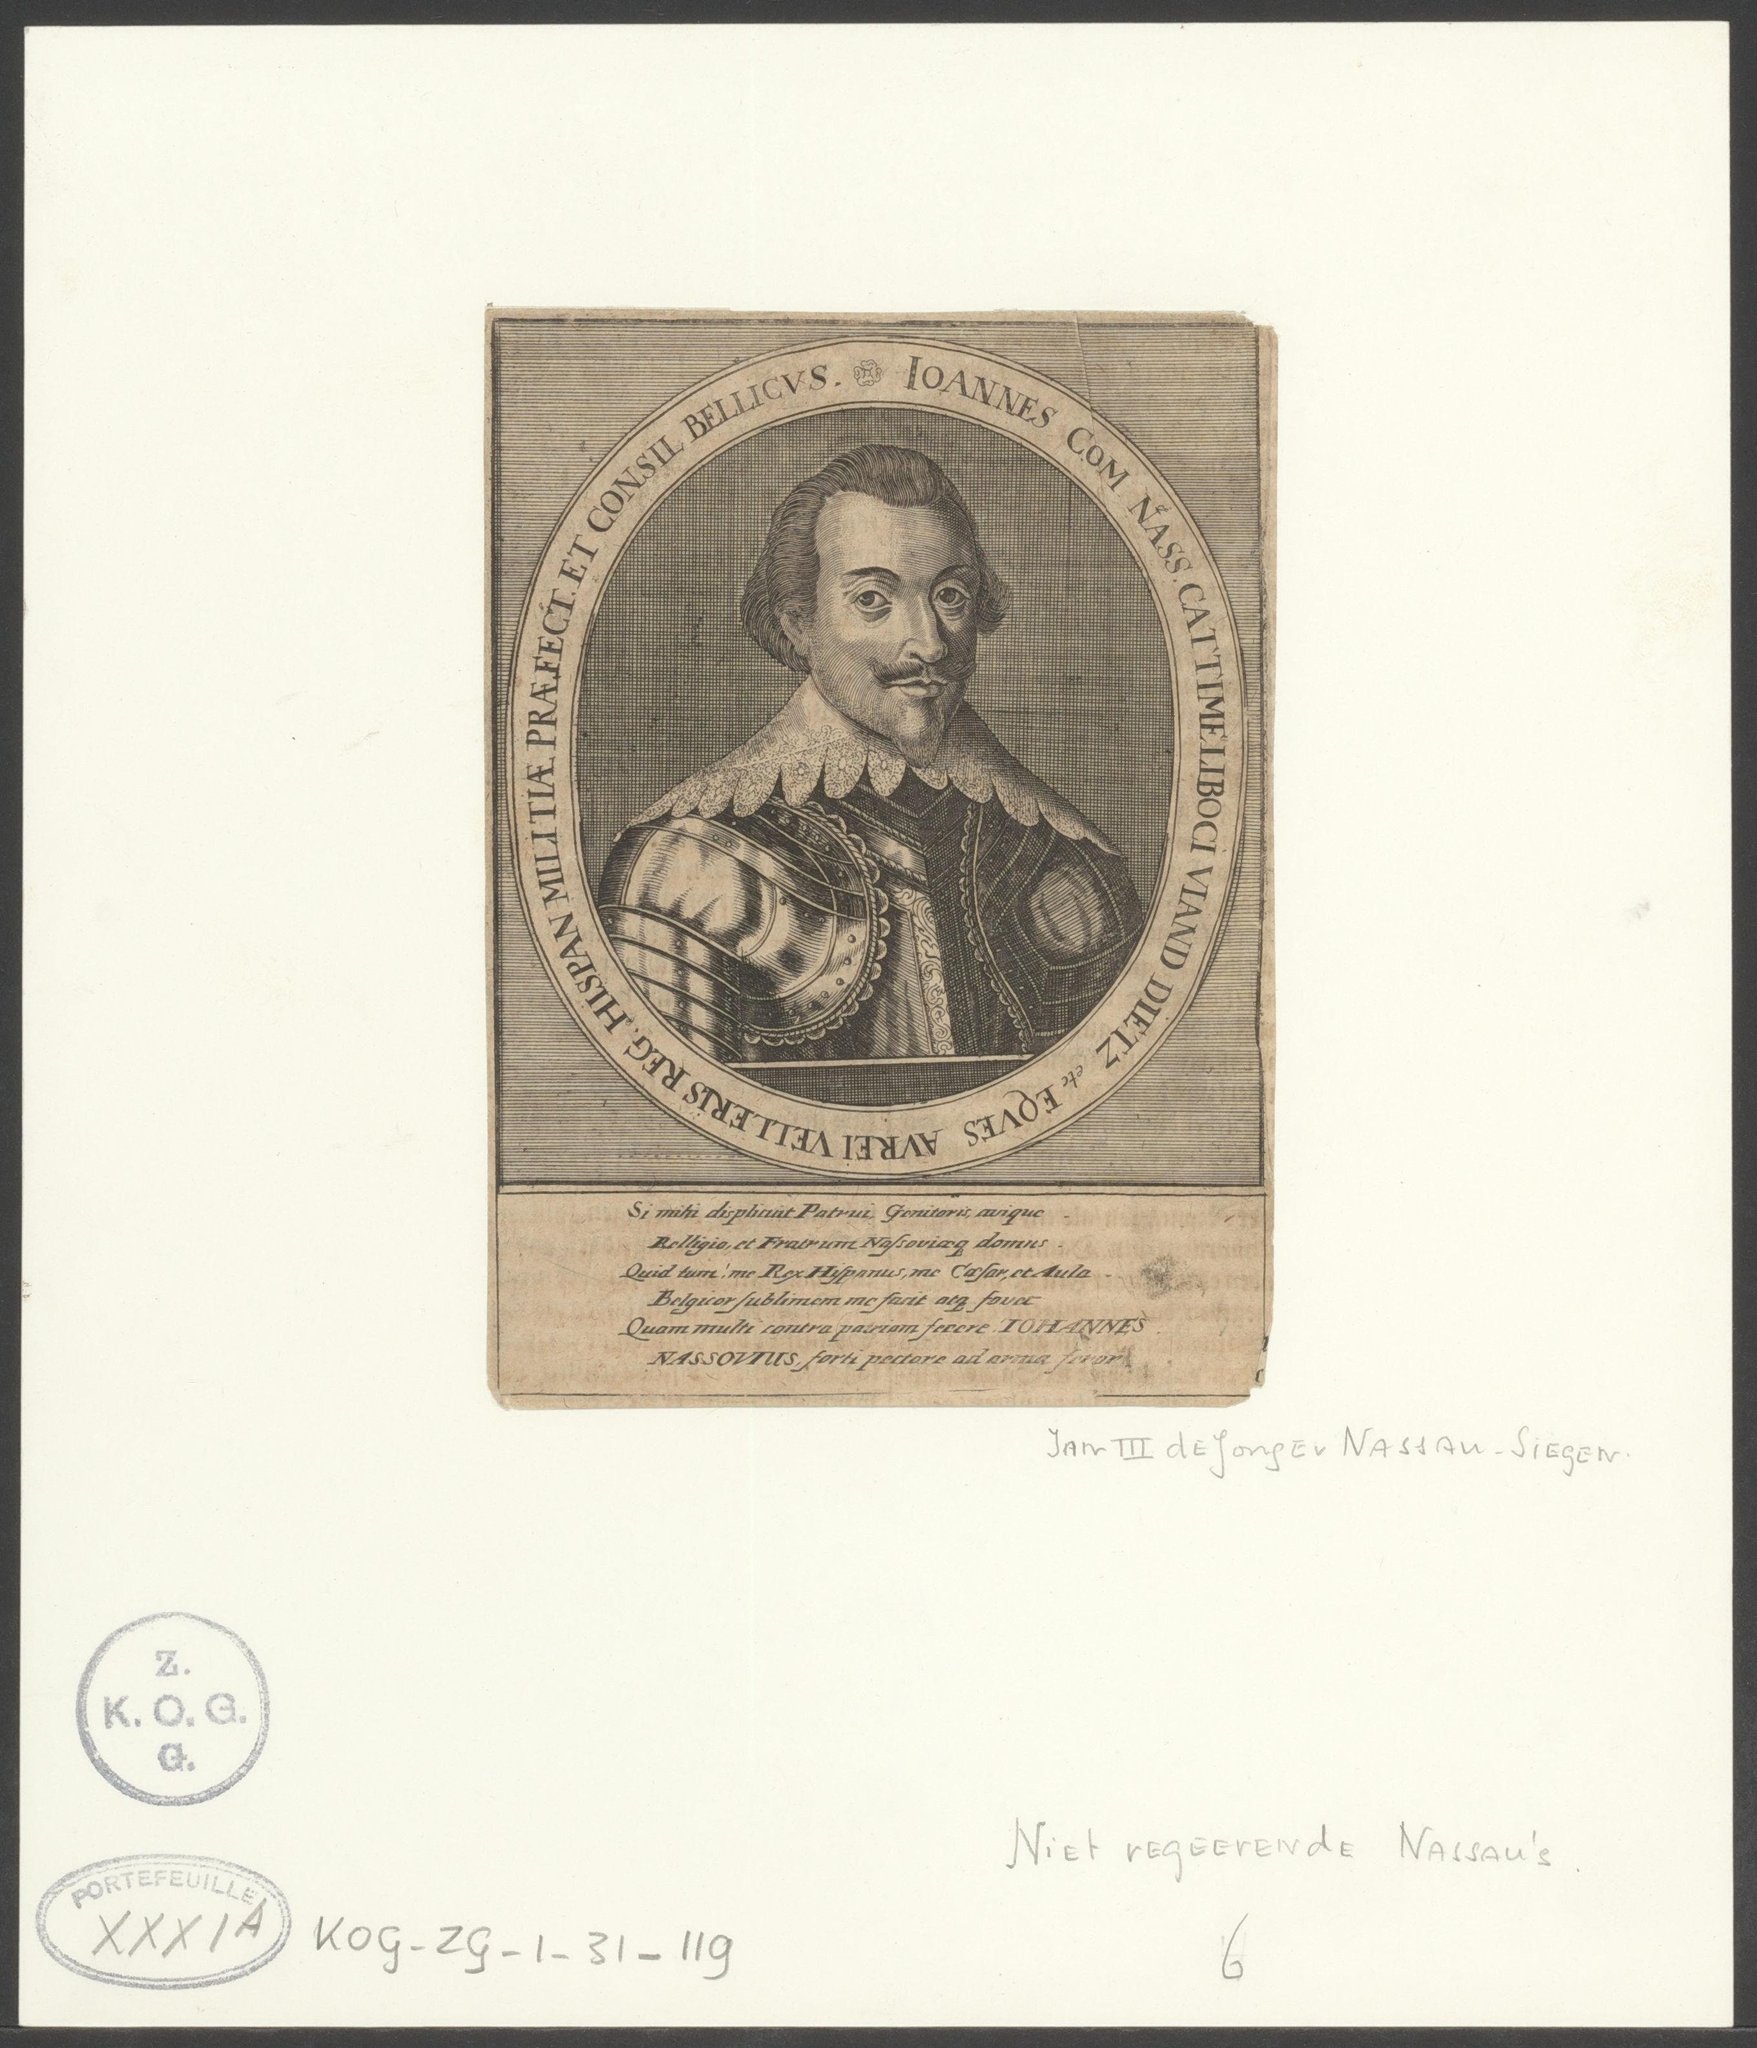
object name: print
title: Portret van Johan VIII, graaf van Nassau-Siegen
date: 1637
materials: paper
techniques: engraving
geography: frankfurt am main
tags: historical persons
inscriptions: stamp, collector's mark: Lugt 1641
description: Portret van Johan VIII in een ovaal met randschrift. In een kader zes regels Latijnse tekst. Onderwerpsrubrieken binnen de Atlas Zeden en Gewoonten: Portretten, Portretten van Vorsten uit het huis van Oranje, Niet regeerende Vorsten.